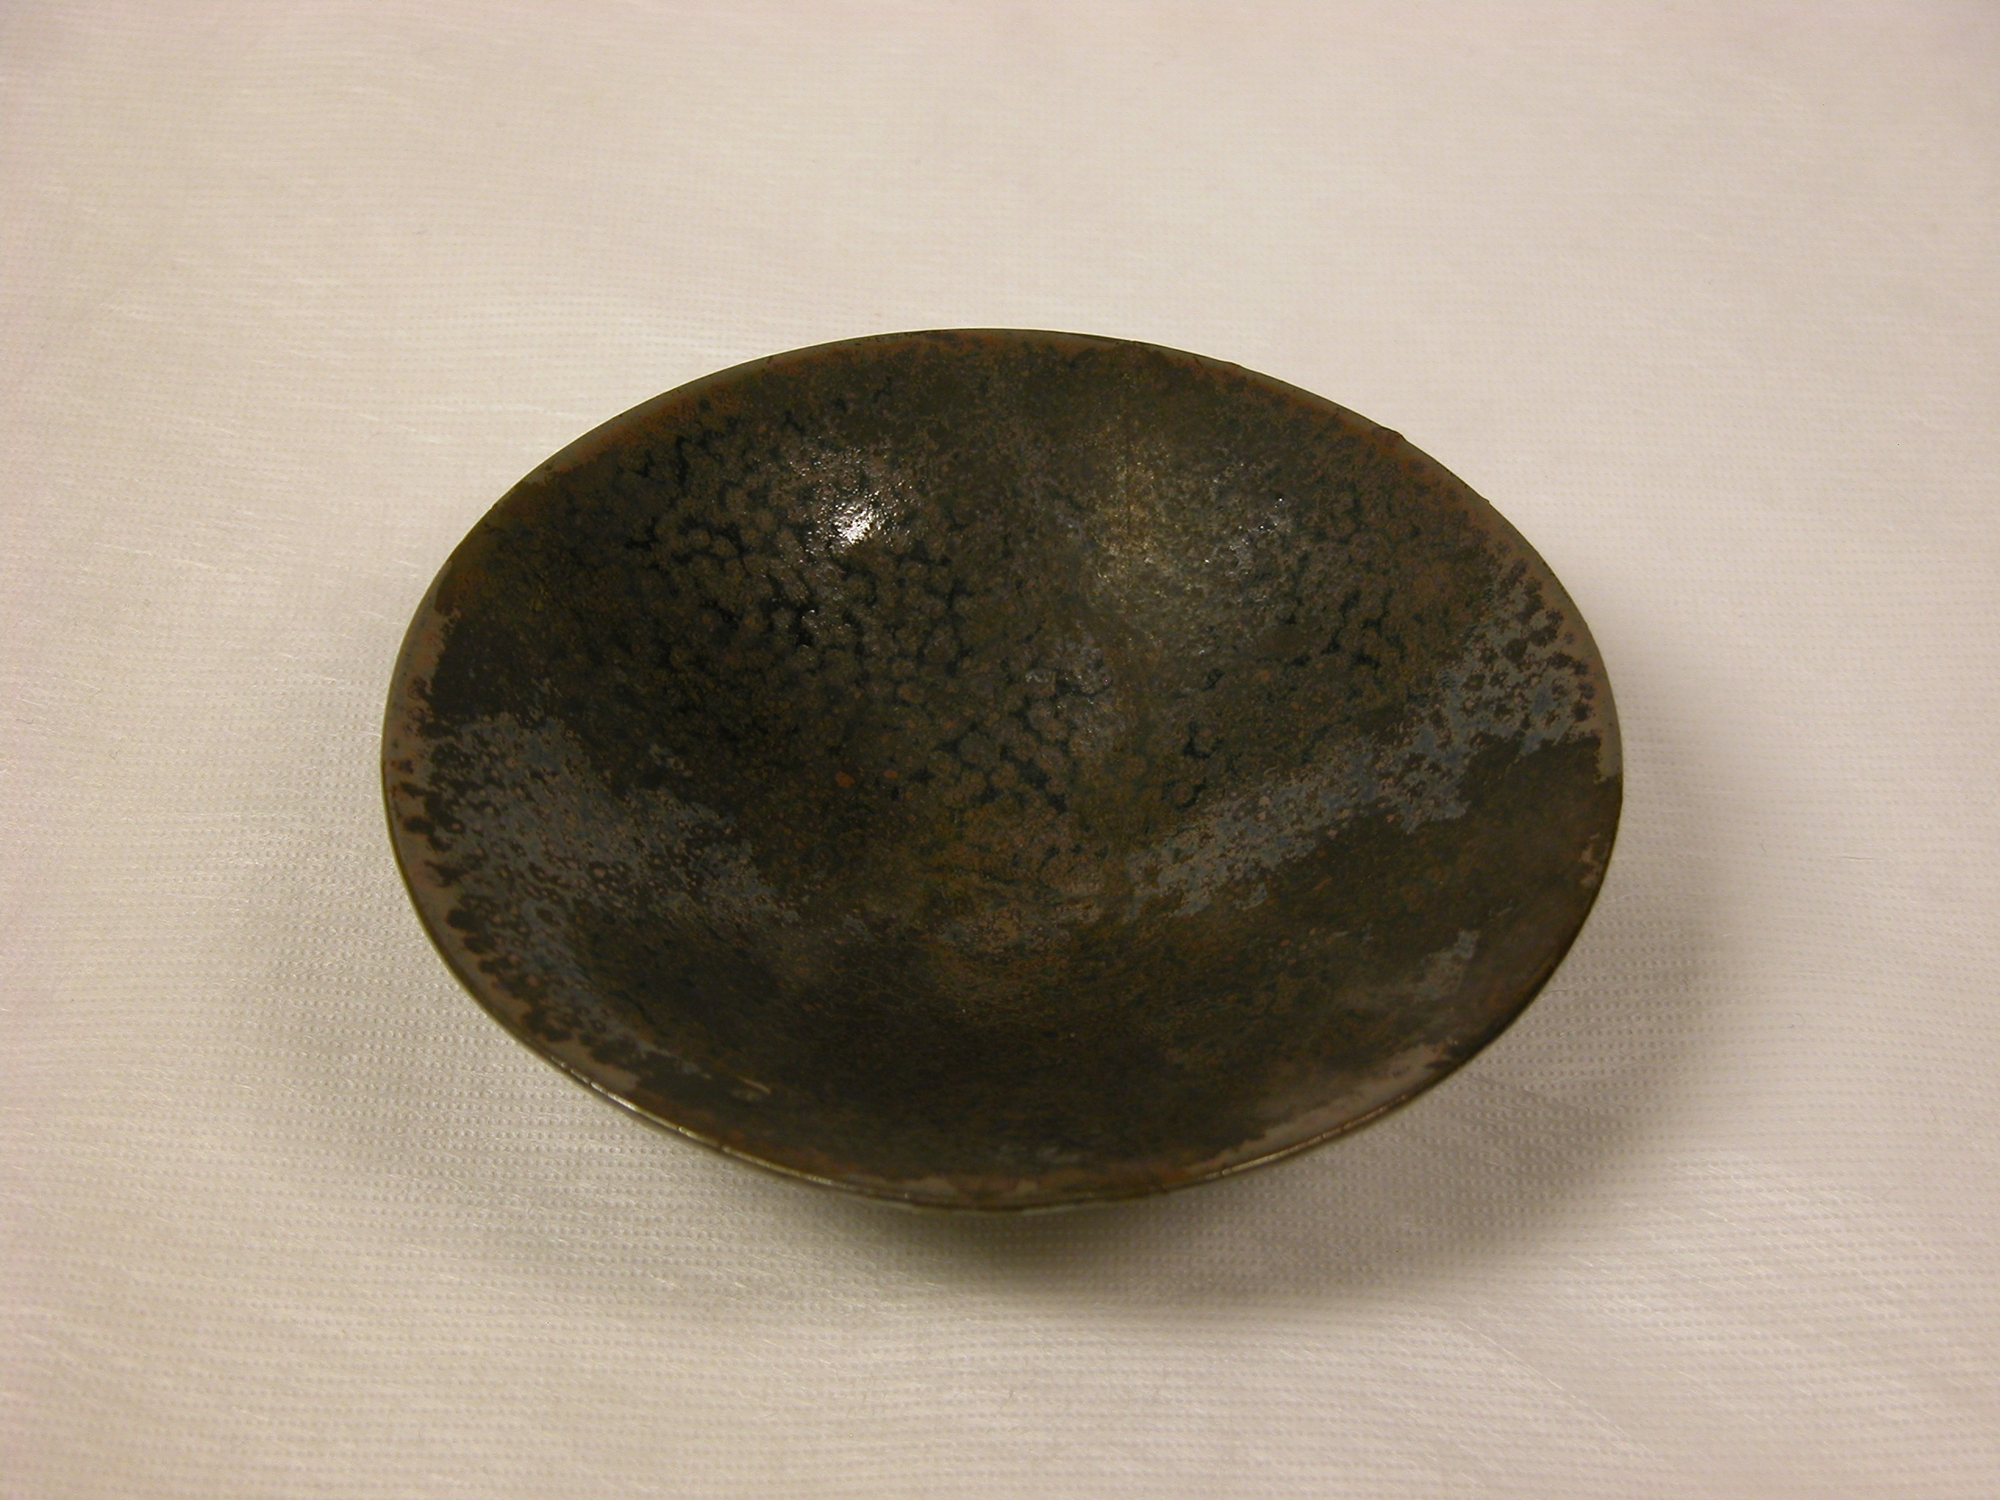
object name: bowl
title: Bowl (one of a pair)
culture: chinese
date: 960-1279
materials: fur, glaze, stoneware